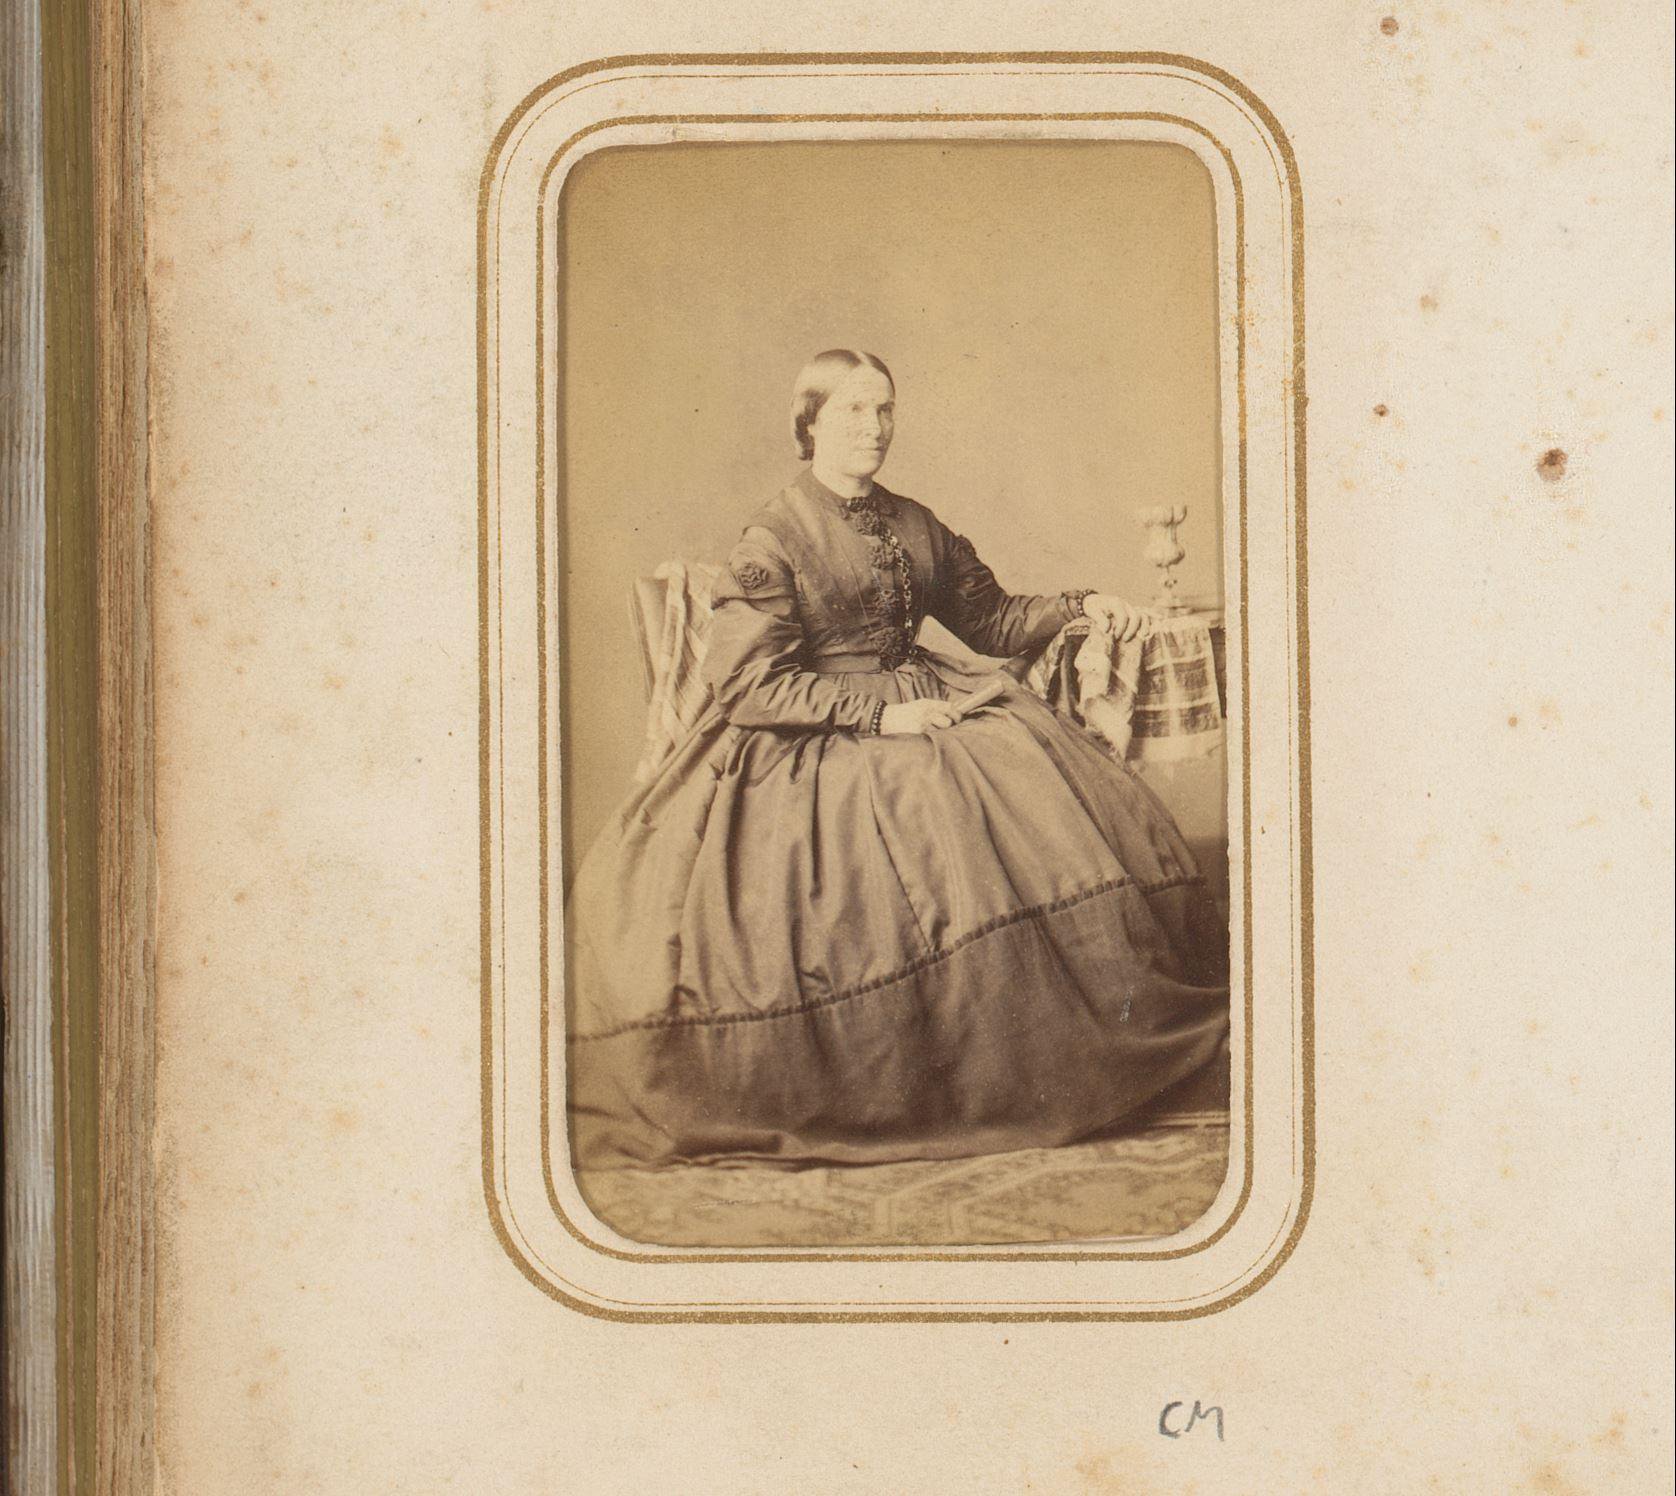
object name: album leaf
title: Portret van een zittende vrouw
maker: robert faulkner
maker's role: fotograaf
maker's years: 1823-1890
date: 1860-1890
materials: cardboard, photographic support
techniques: albumen print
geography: london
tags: sitting figure - aa - female human figure, historical persons - bb - woman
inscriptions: inscription: ‘Robert Faulker/ Portrait Painter & Photographer/ 46, Kensington Gardens Square/ Westbourne Grove/ Bayswater W.’